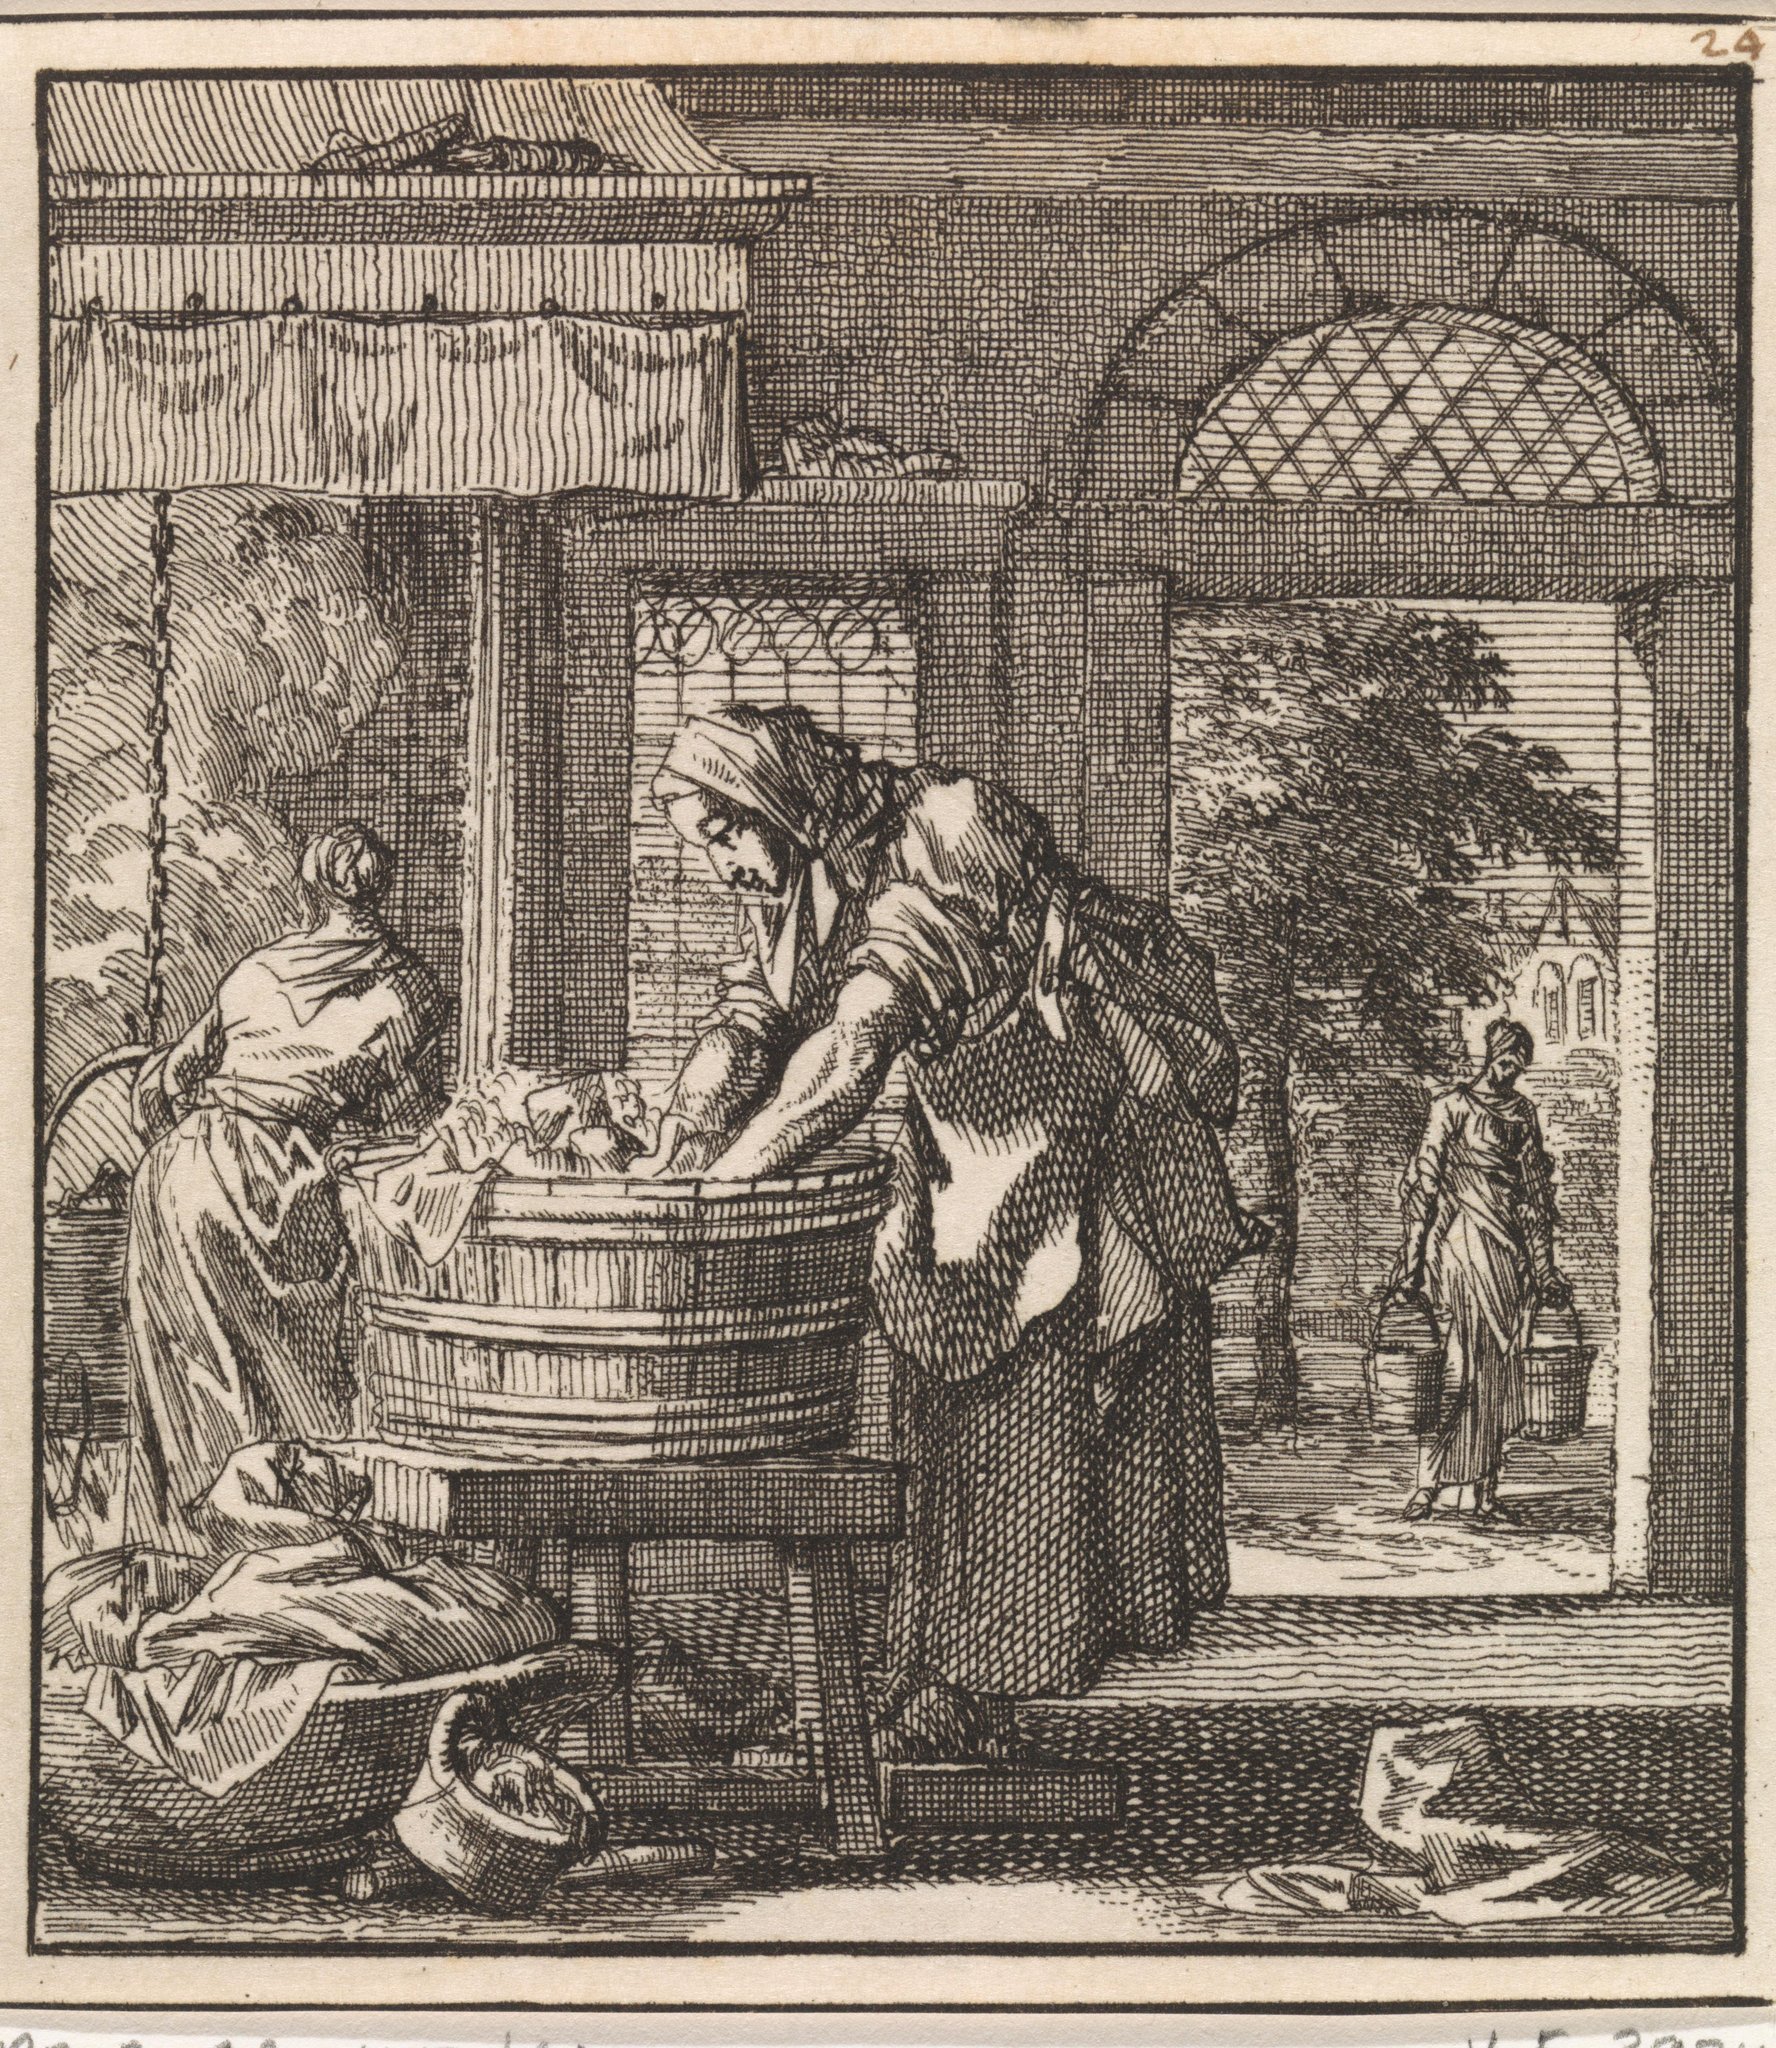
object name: print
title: Vrouw wast linnengoed in een wastobbe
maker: jan luyken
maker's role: draughtsman, print maker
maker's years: 1649-1712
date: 1711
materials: paper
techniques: etching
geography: amsterdam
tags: laundering, linen (material ~ textile industry)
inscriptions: collector's mark: Lugt 2228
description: Proefdruk van illustratie voor: Luyken, Jan. Het leerzaam huisraad, vertoond in vyftig konstige figuuren, met godlyke spreuken en stichtelyke verzen: Pieter Arentsz. II (wed.) en Cornelis van der Sys, 1711, p. 84.